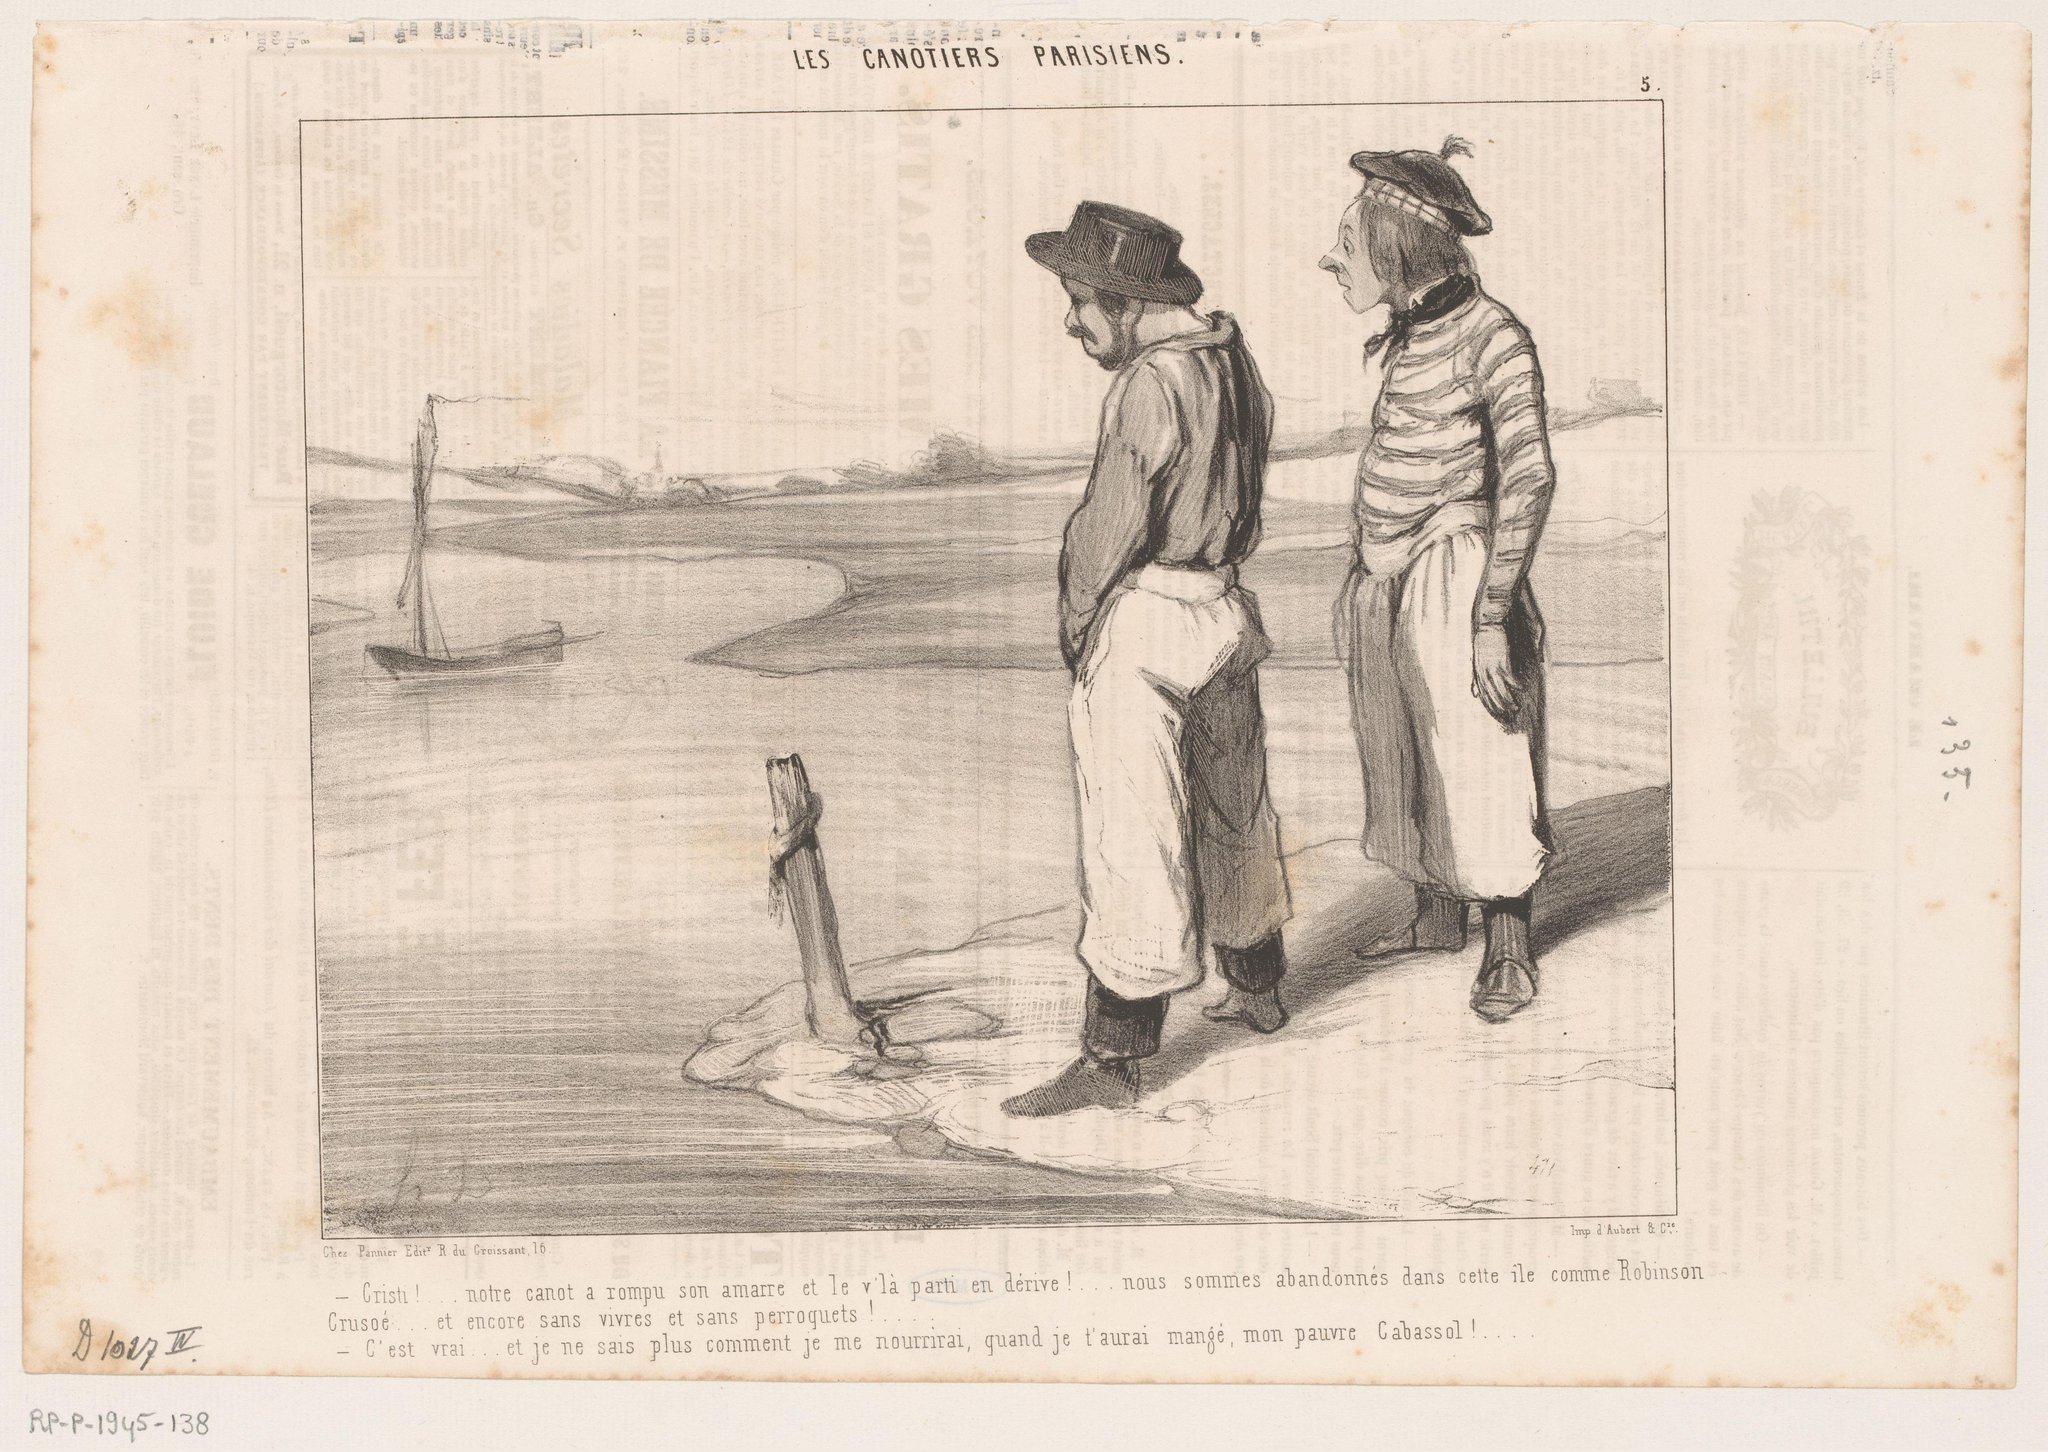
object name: cartoon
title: Karikatuur van twee schippers die hun boot zien wegdrijven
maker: honoré daumier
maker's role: draughtsman, painter, print maker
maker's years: 1808-1879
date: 1843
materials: paper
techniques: lithograph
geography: paris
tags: island, caricatures (human types), river, rowing-boat, canoe, etc.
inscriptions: number: ‘135’, collector's mark: Lugt 2228a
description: Prent gepubliceerd in: Le Charivari, Aubert: Parijs, 30-04-1843. Le Charivari was een humoristische krant met karikaturen en (politieke) cartoons.